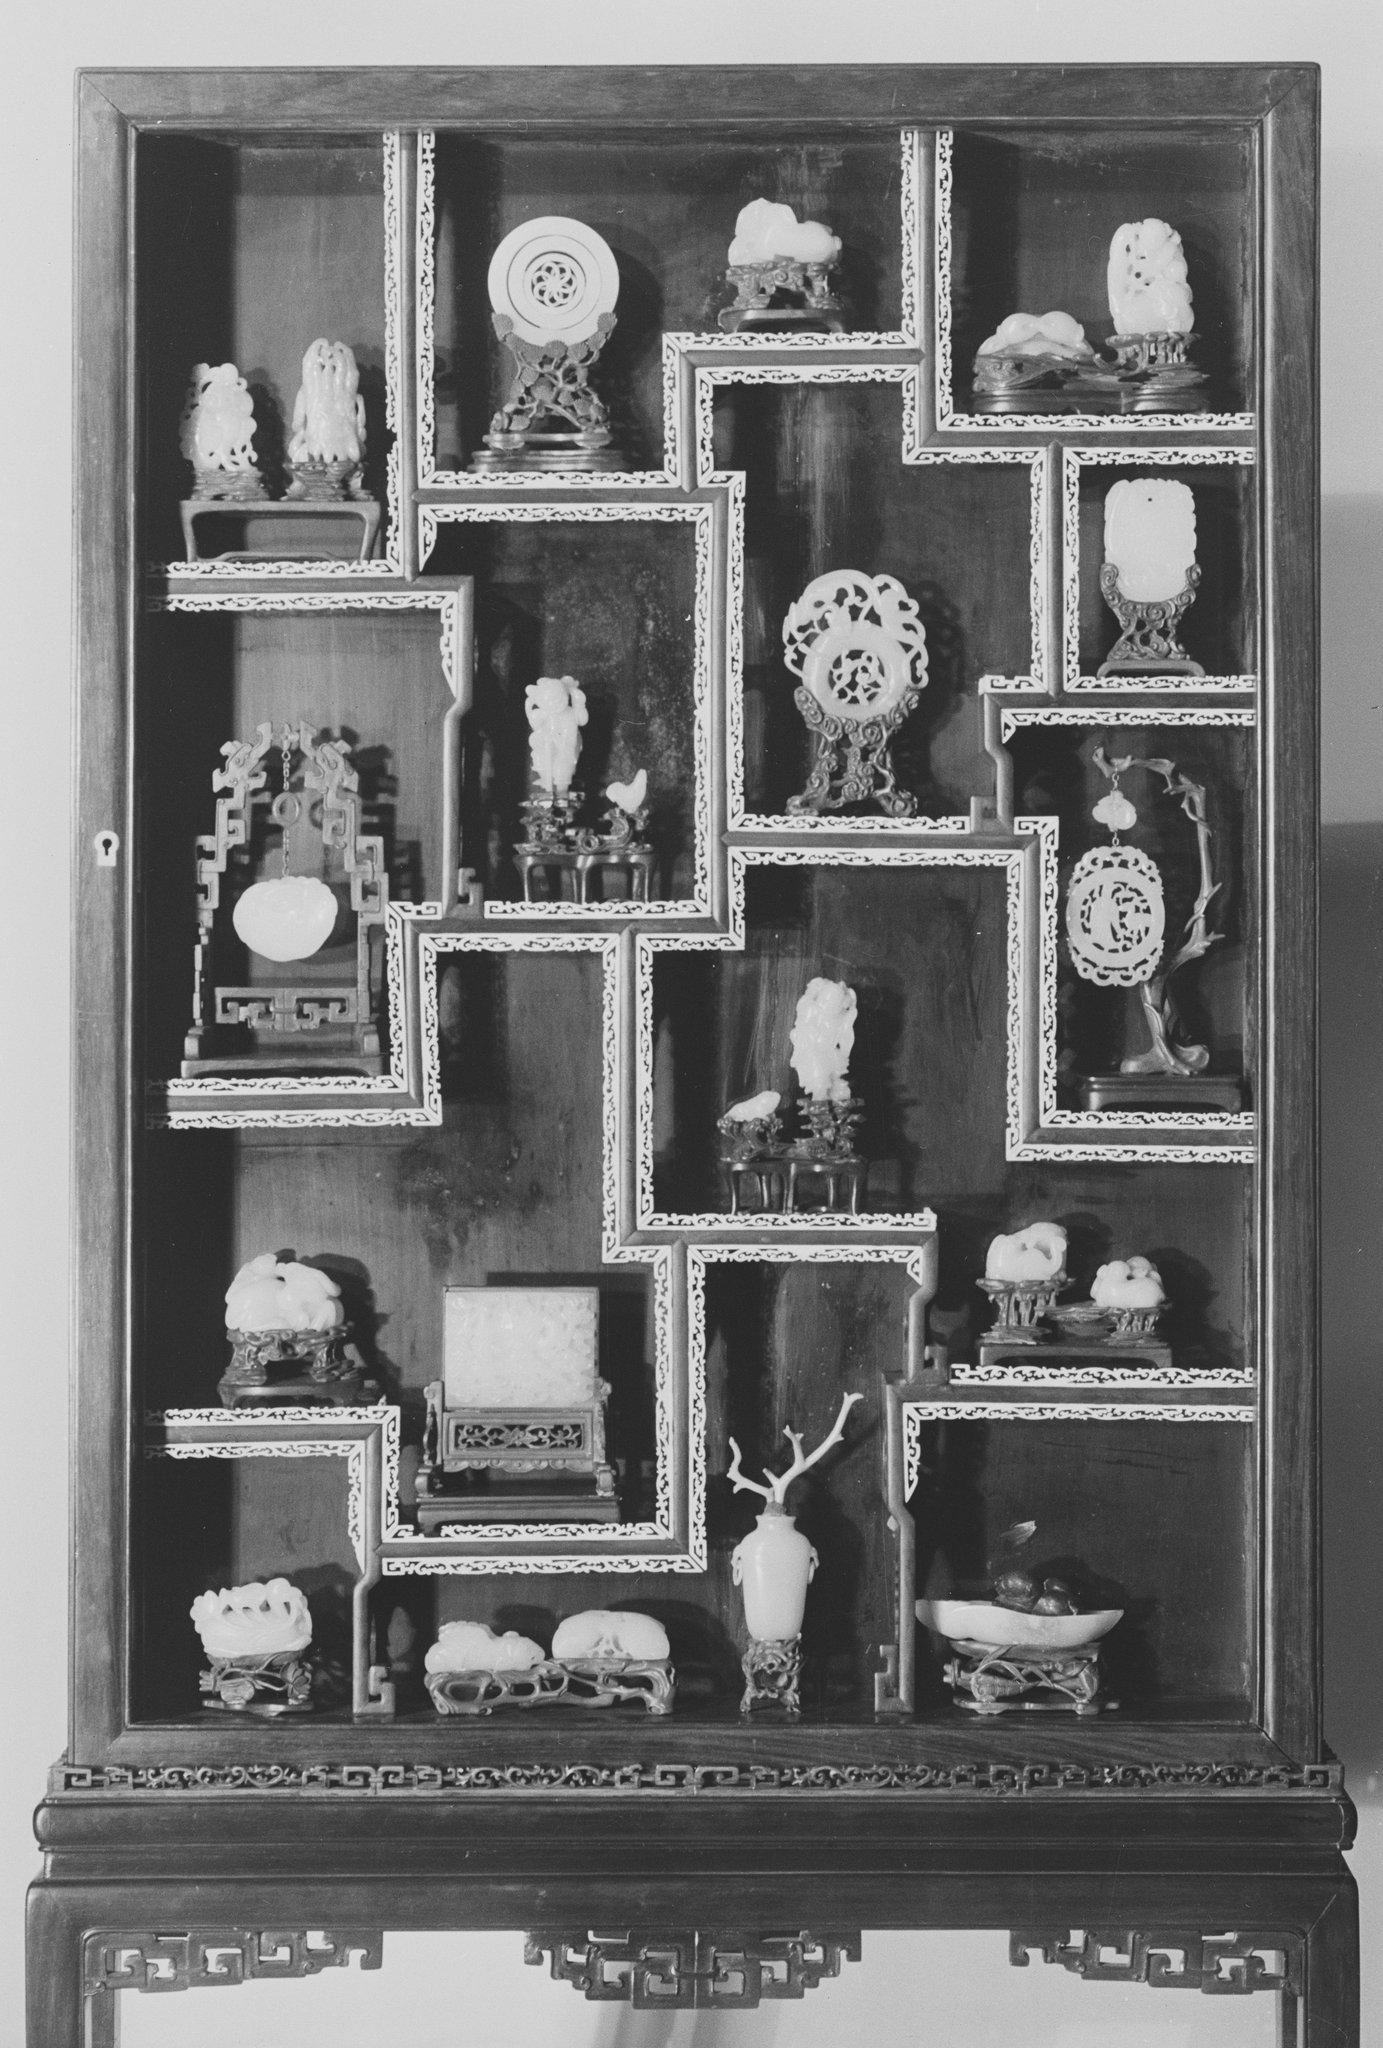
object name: ornament in vitrine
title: Vitrine Containing Twenty-Three Ornaments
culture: chinese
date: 1701-1900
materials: ivory, jade, wood